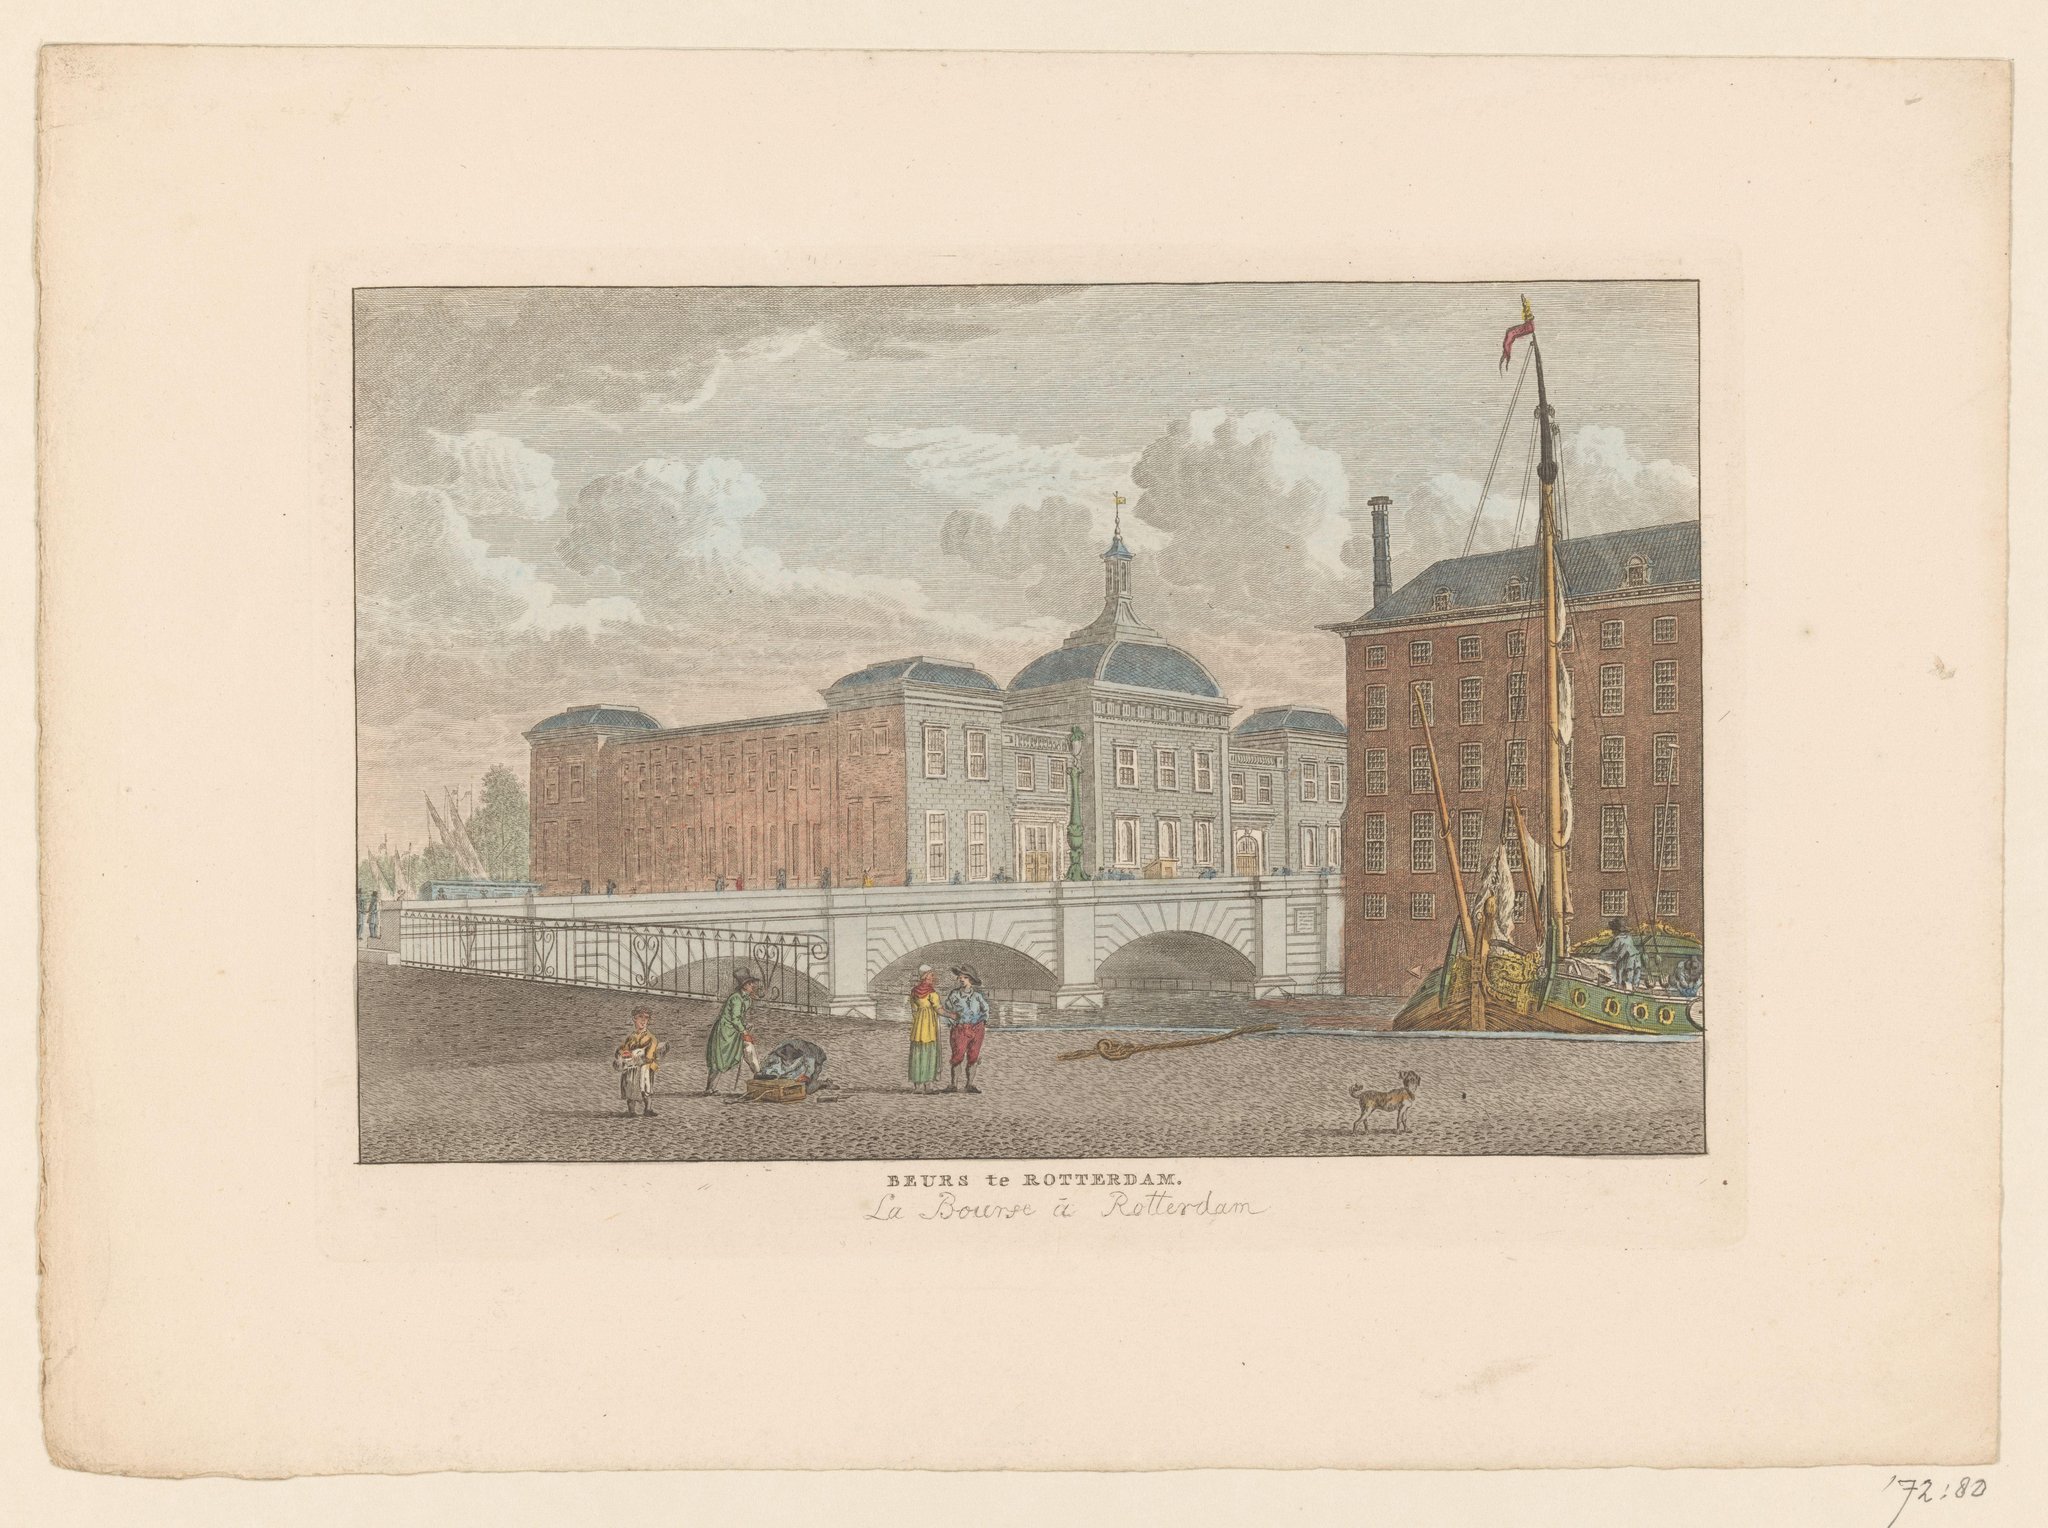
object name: print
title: Gezicht op de Beurs in Rotterdam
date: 1786-1792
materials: paper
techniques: engraving, etching, hand coloring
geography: amsterdam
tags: stock exchange, stock-market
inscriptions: collector's mark: Lugt 2228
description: Huidige staat van prent uitgegeven als onderdeel van een plaatwerk uit ca. 1824-1825 met 74 (ongenummerde) platen van de belangrijkste topografische gezichten en verschillende zeden en gewoonten in het Verenigd Koninkrijk der Nederlanden, getiteld 'Tableau des principales vues des palais et édifices : représentations et des coutumes et usages, dans les provinces septentrionales du Royaume des Pays-Bas'. Eerdere staat gebruikt in: Vaderlandsche gezichten, of afbeeldingen van den tegenwoordigen staat der Vereenigde Nederlanden (…). Amsterdam: Hendrik Gartman, Willem Vermandel en Jan Willem Smit, 1786-1792. Uitgegeven in afleveringen met ieder een eigen bifolium en inhoudsopgave. Alle prenten in deze publicatie zijn gegraveerd door Carel Frederik Bendorp (I) en, in de meeste gevallen, gebaseerd op tekeningen van Jan Bulthuis.